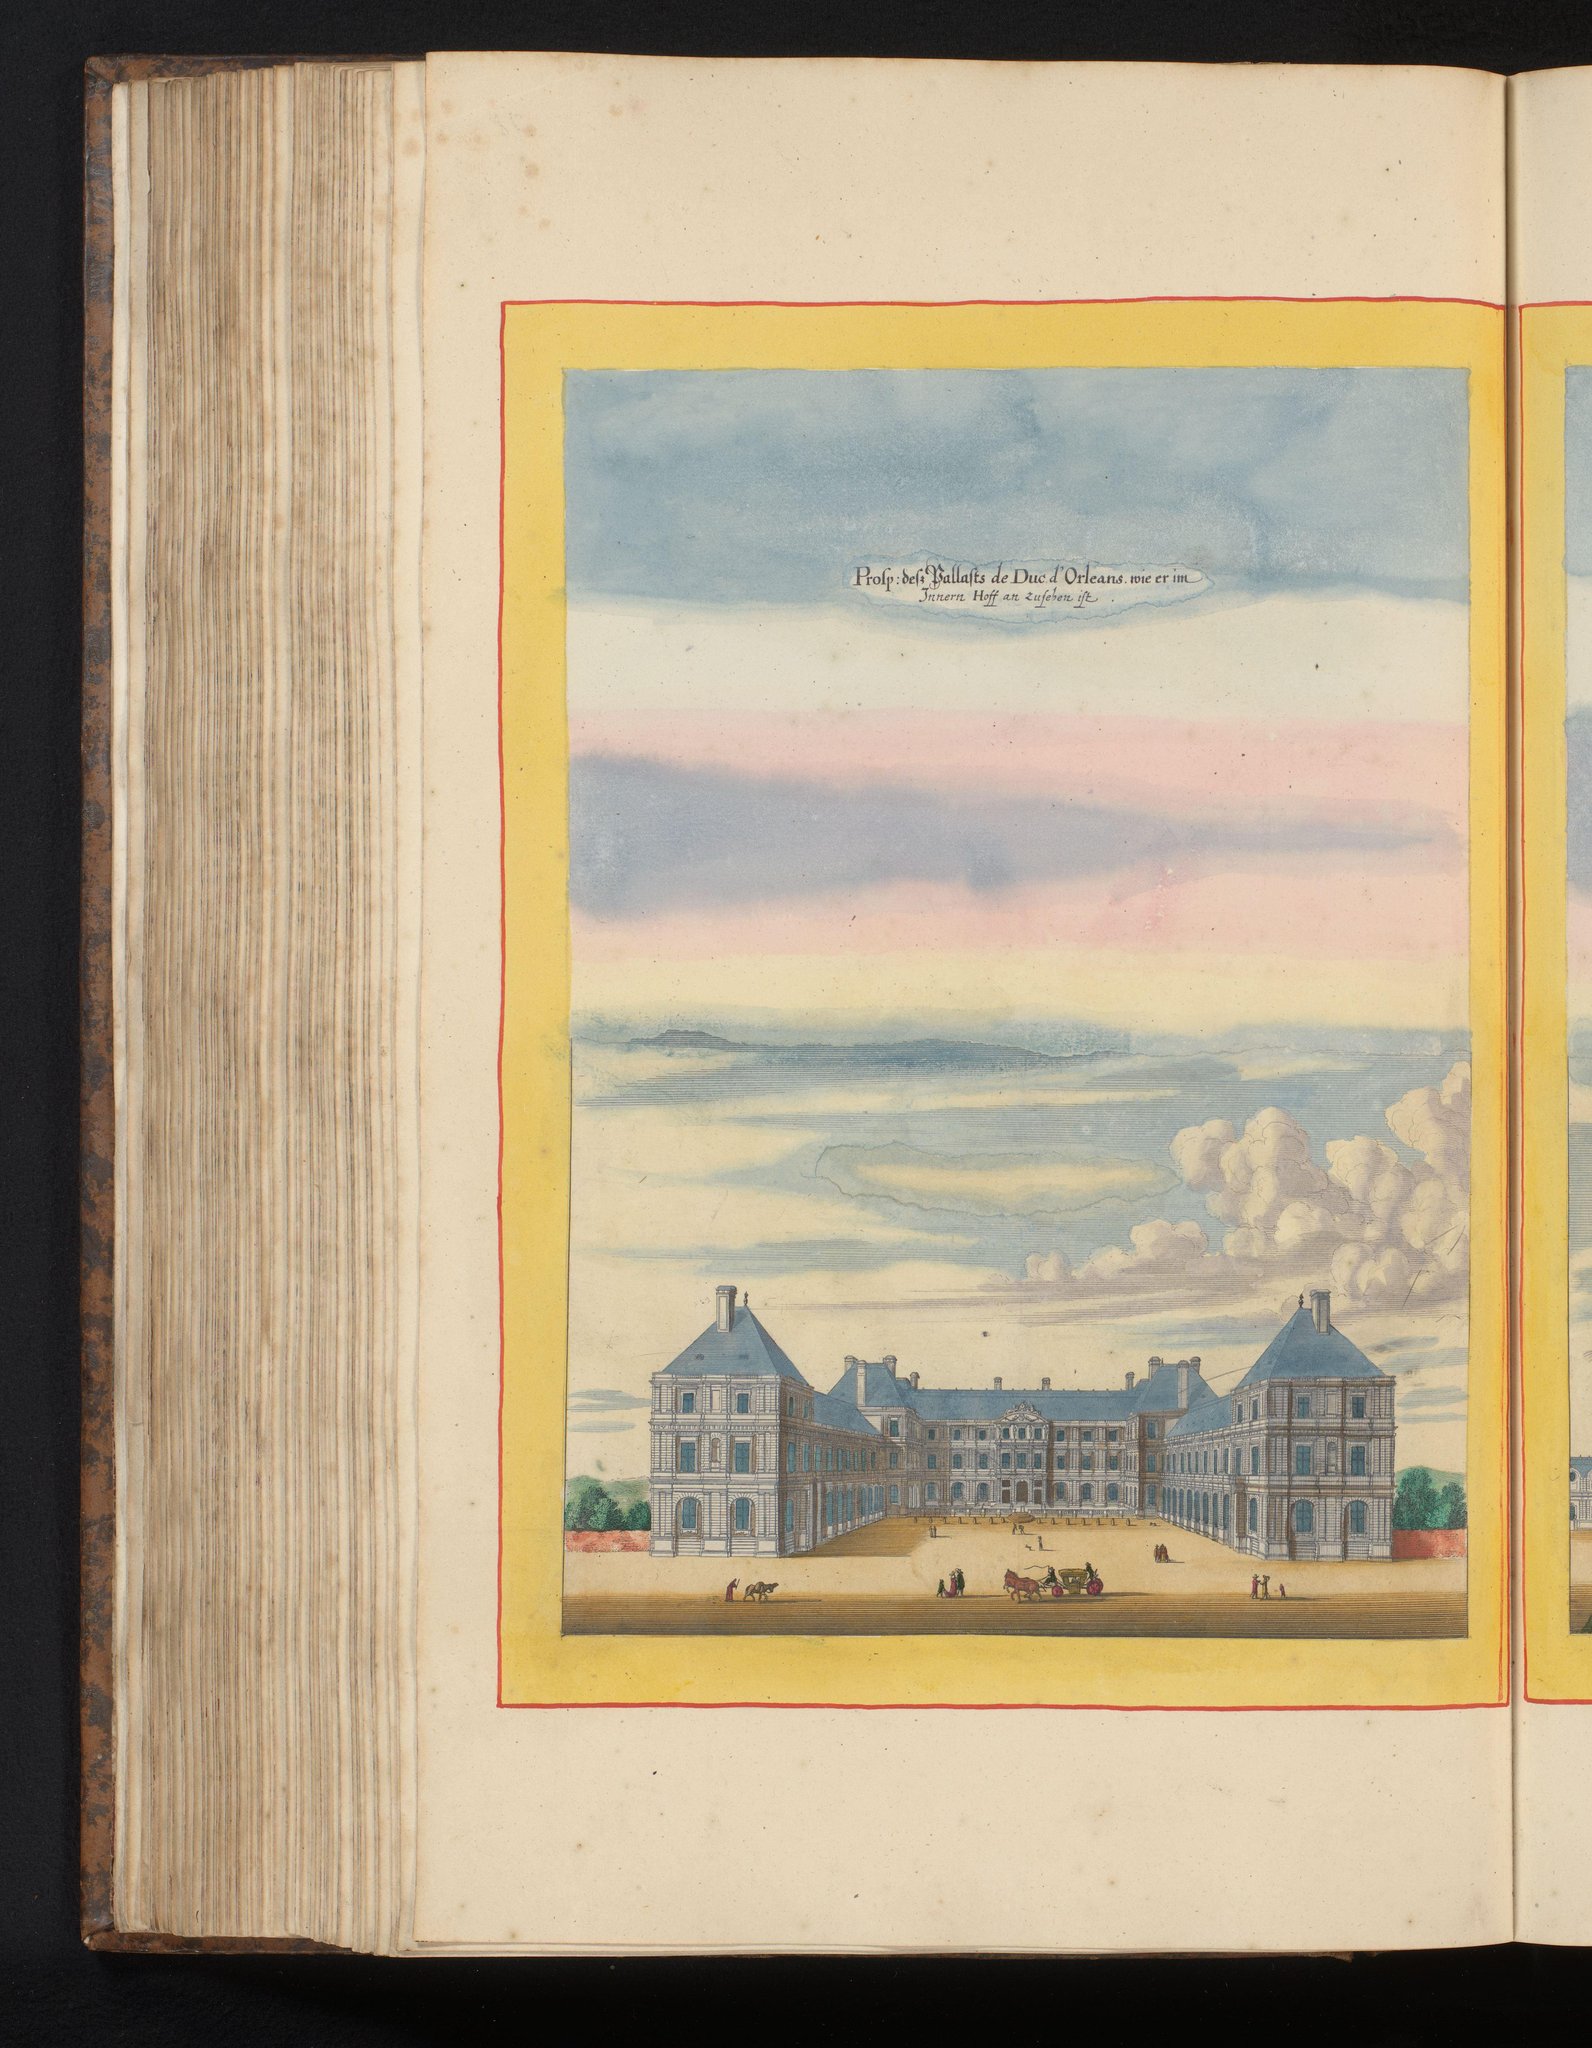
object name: print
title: Gezicht op de binnenhof van Palais du Luxembourg te Parijs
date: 1655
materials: paper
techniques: engraving, etching, hand coloring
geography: the hague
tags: palace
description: Prent origineel vervaardigd als boekillustratie voor: Zeiller, Martin. Topographia Galliae, oder Beschreibung und Contrafaitung der vornehmbsten und bekantisten Oerter in dem mächtigen und grossen Königreich Frankreich, 13 delen. Frankfurt am Main: Caspar Merian, 1655-1661. De prent werd voor het eerst gepubliceerd in deel 1: Topographia Galliae, 1655. De prent is langs de bovenrand van de voorstelling afgescheurd. Het bovenste gedeelte is hoger opgeplakt, zodat de lucht hoger is geworden en het formaat van de voorstelling past bij de andere groot formaatvoorstellingen in het album. De voorstelling is aan de bovenzijde aangevuld met een geschilderde lucht.